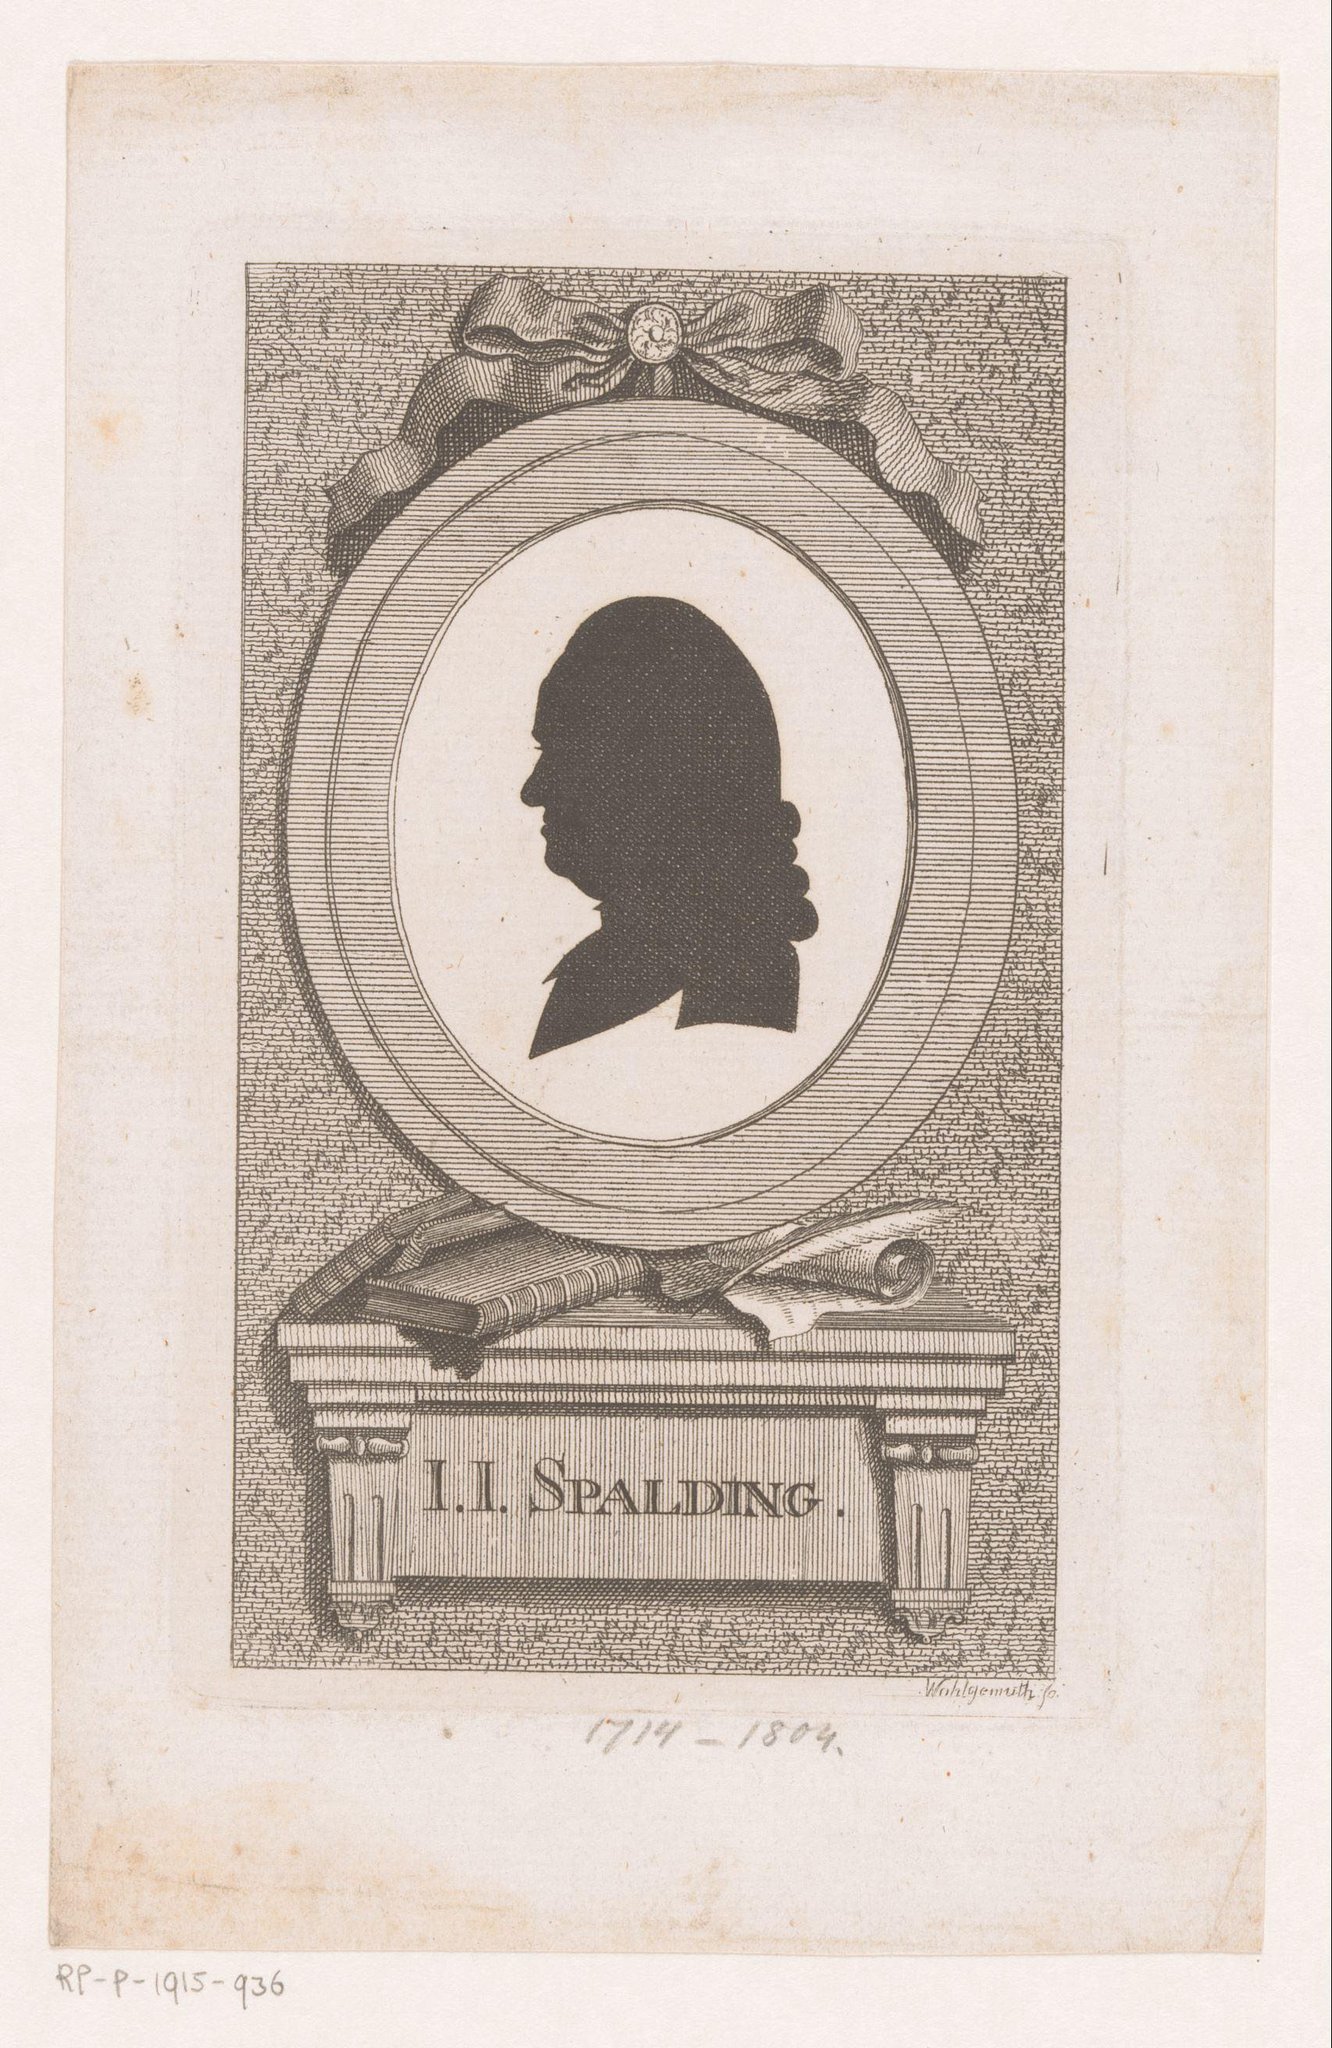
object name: print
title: Silhouetportret van Johann Joachim Spalding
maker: wohlgemut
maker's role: print maker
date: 1735-1799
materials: paper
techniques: etching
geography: germany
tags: johann joachim spalding, historical persons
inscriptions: collector's mark: Lugt 2228